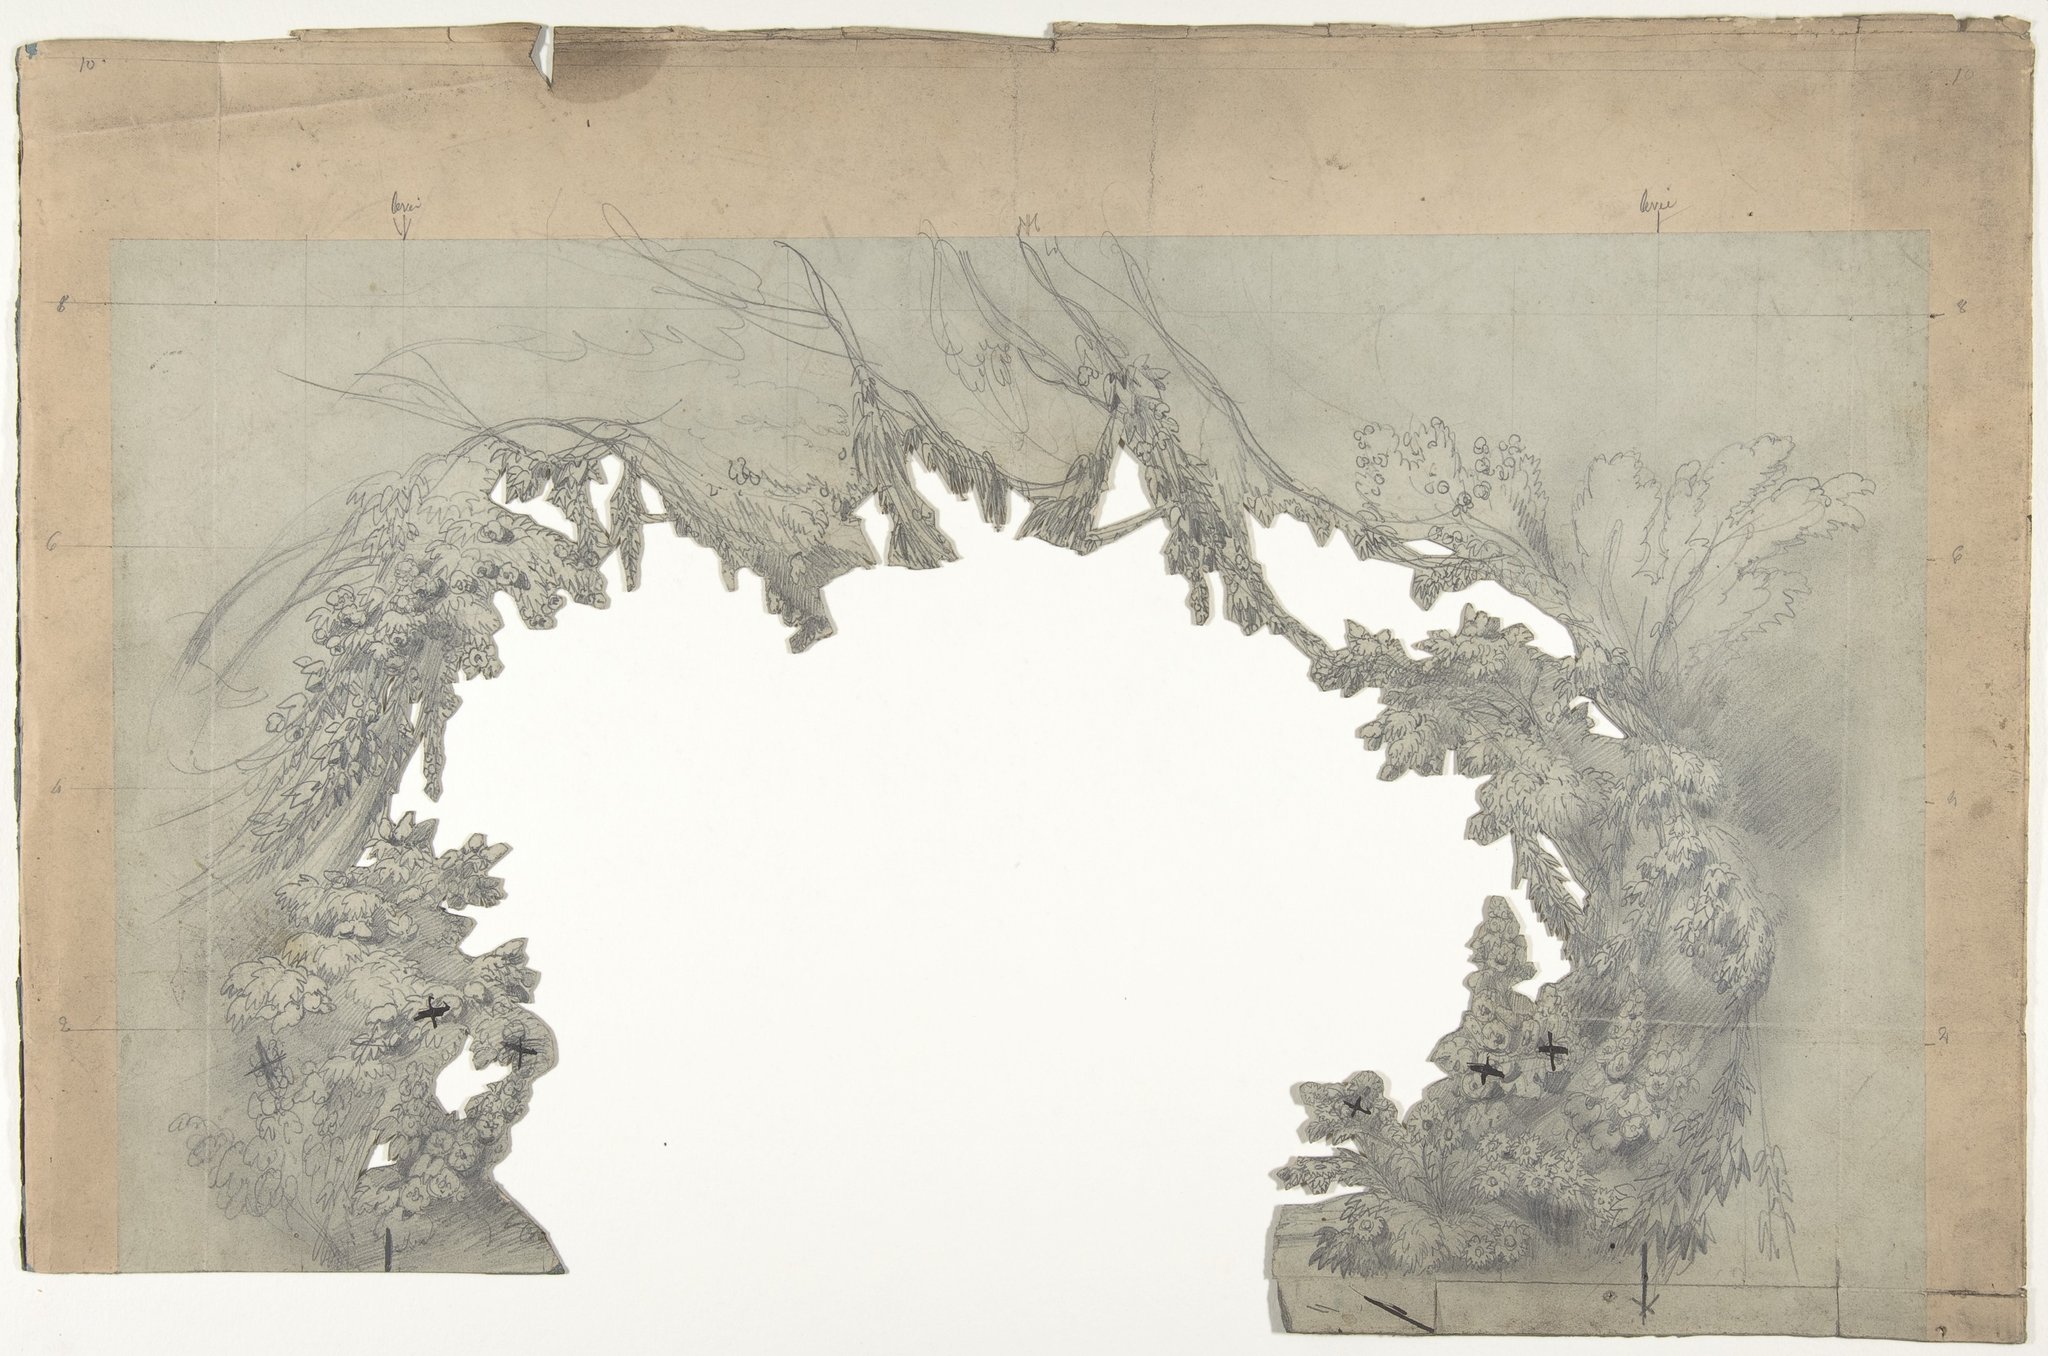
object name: drawing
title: Design for a Stage Set at the Opéra, Paris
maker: eugène cicéri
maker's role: artist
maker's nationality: french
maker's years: 1813-1890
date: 1801-1900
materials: graphite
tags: stage design